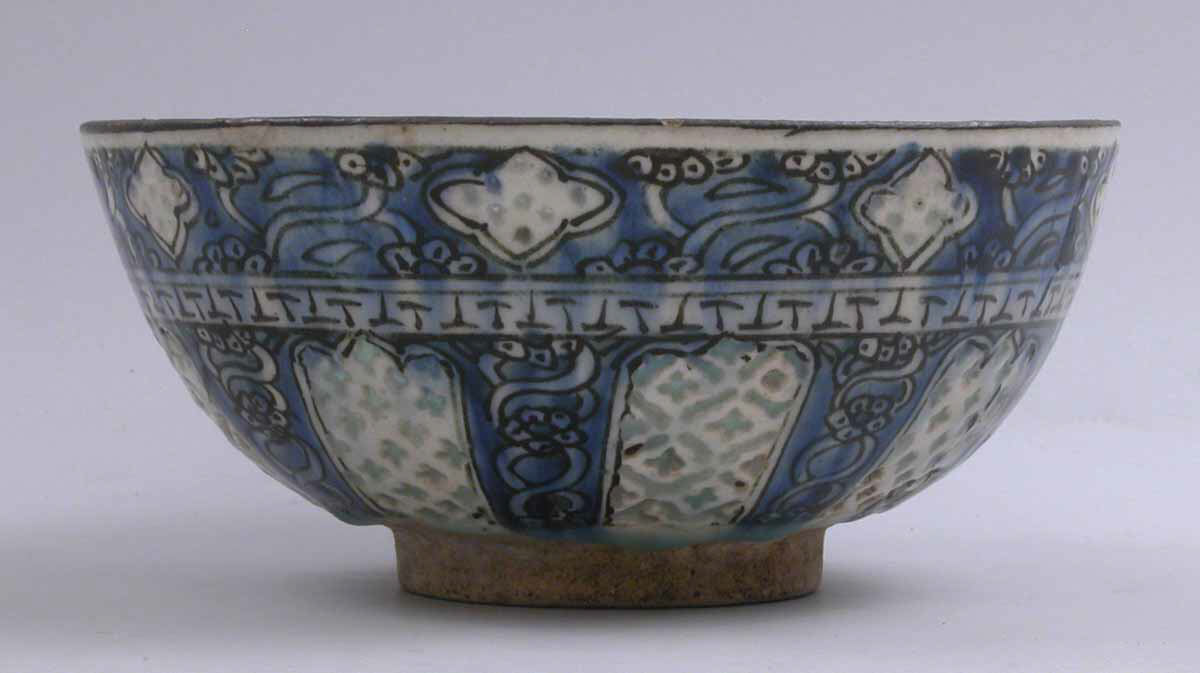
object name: bowl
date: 1301-1400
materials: glaze, stonepaste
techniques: underglaze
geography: egypt